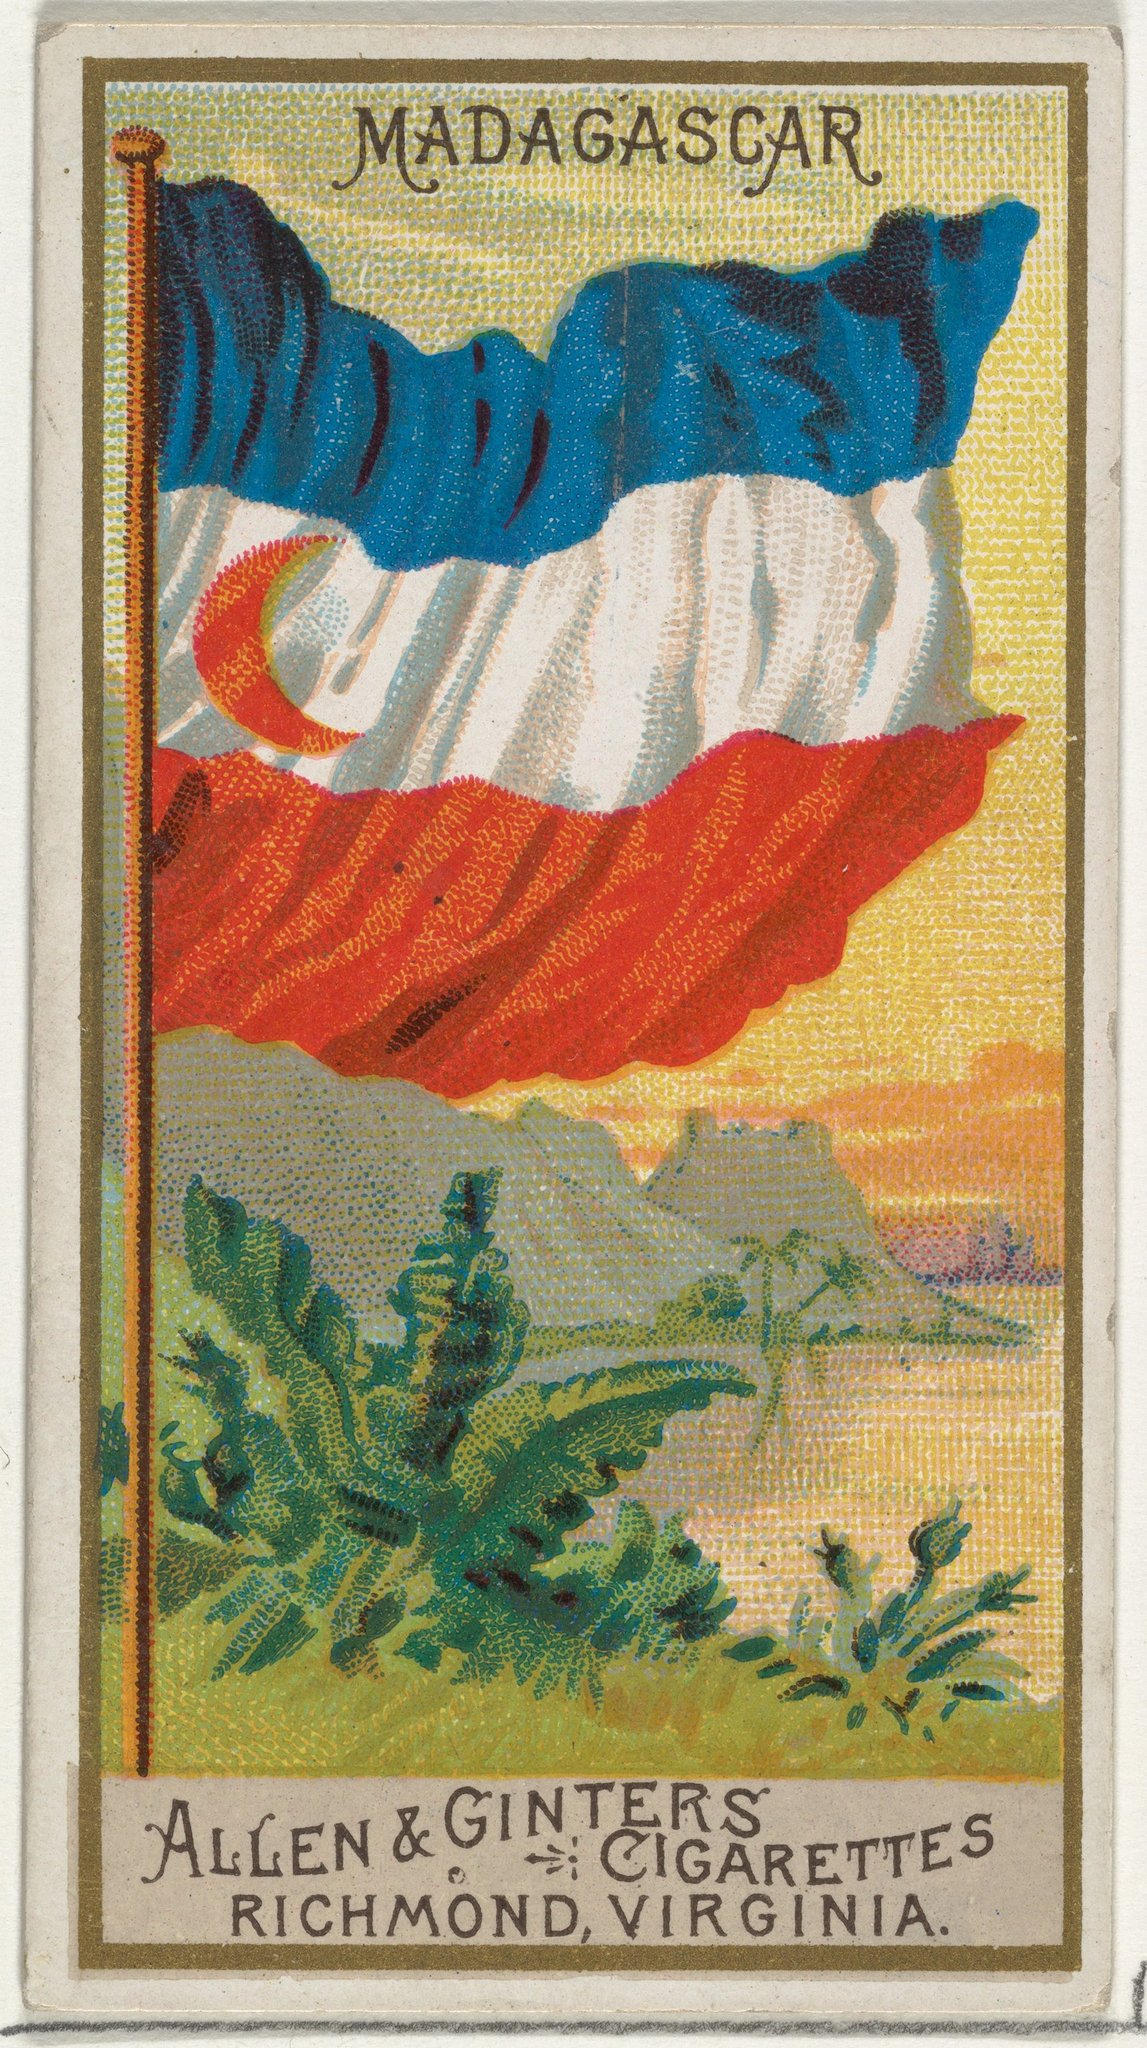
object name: print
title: Madagascar, from Flags of All Nations, Series 2 (N10) for Allen & Ginter Cigarettes Brands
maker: allen & ginter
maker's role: publisher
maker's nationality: american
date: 1890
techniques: color lithograph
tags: flags